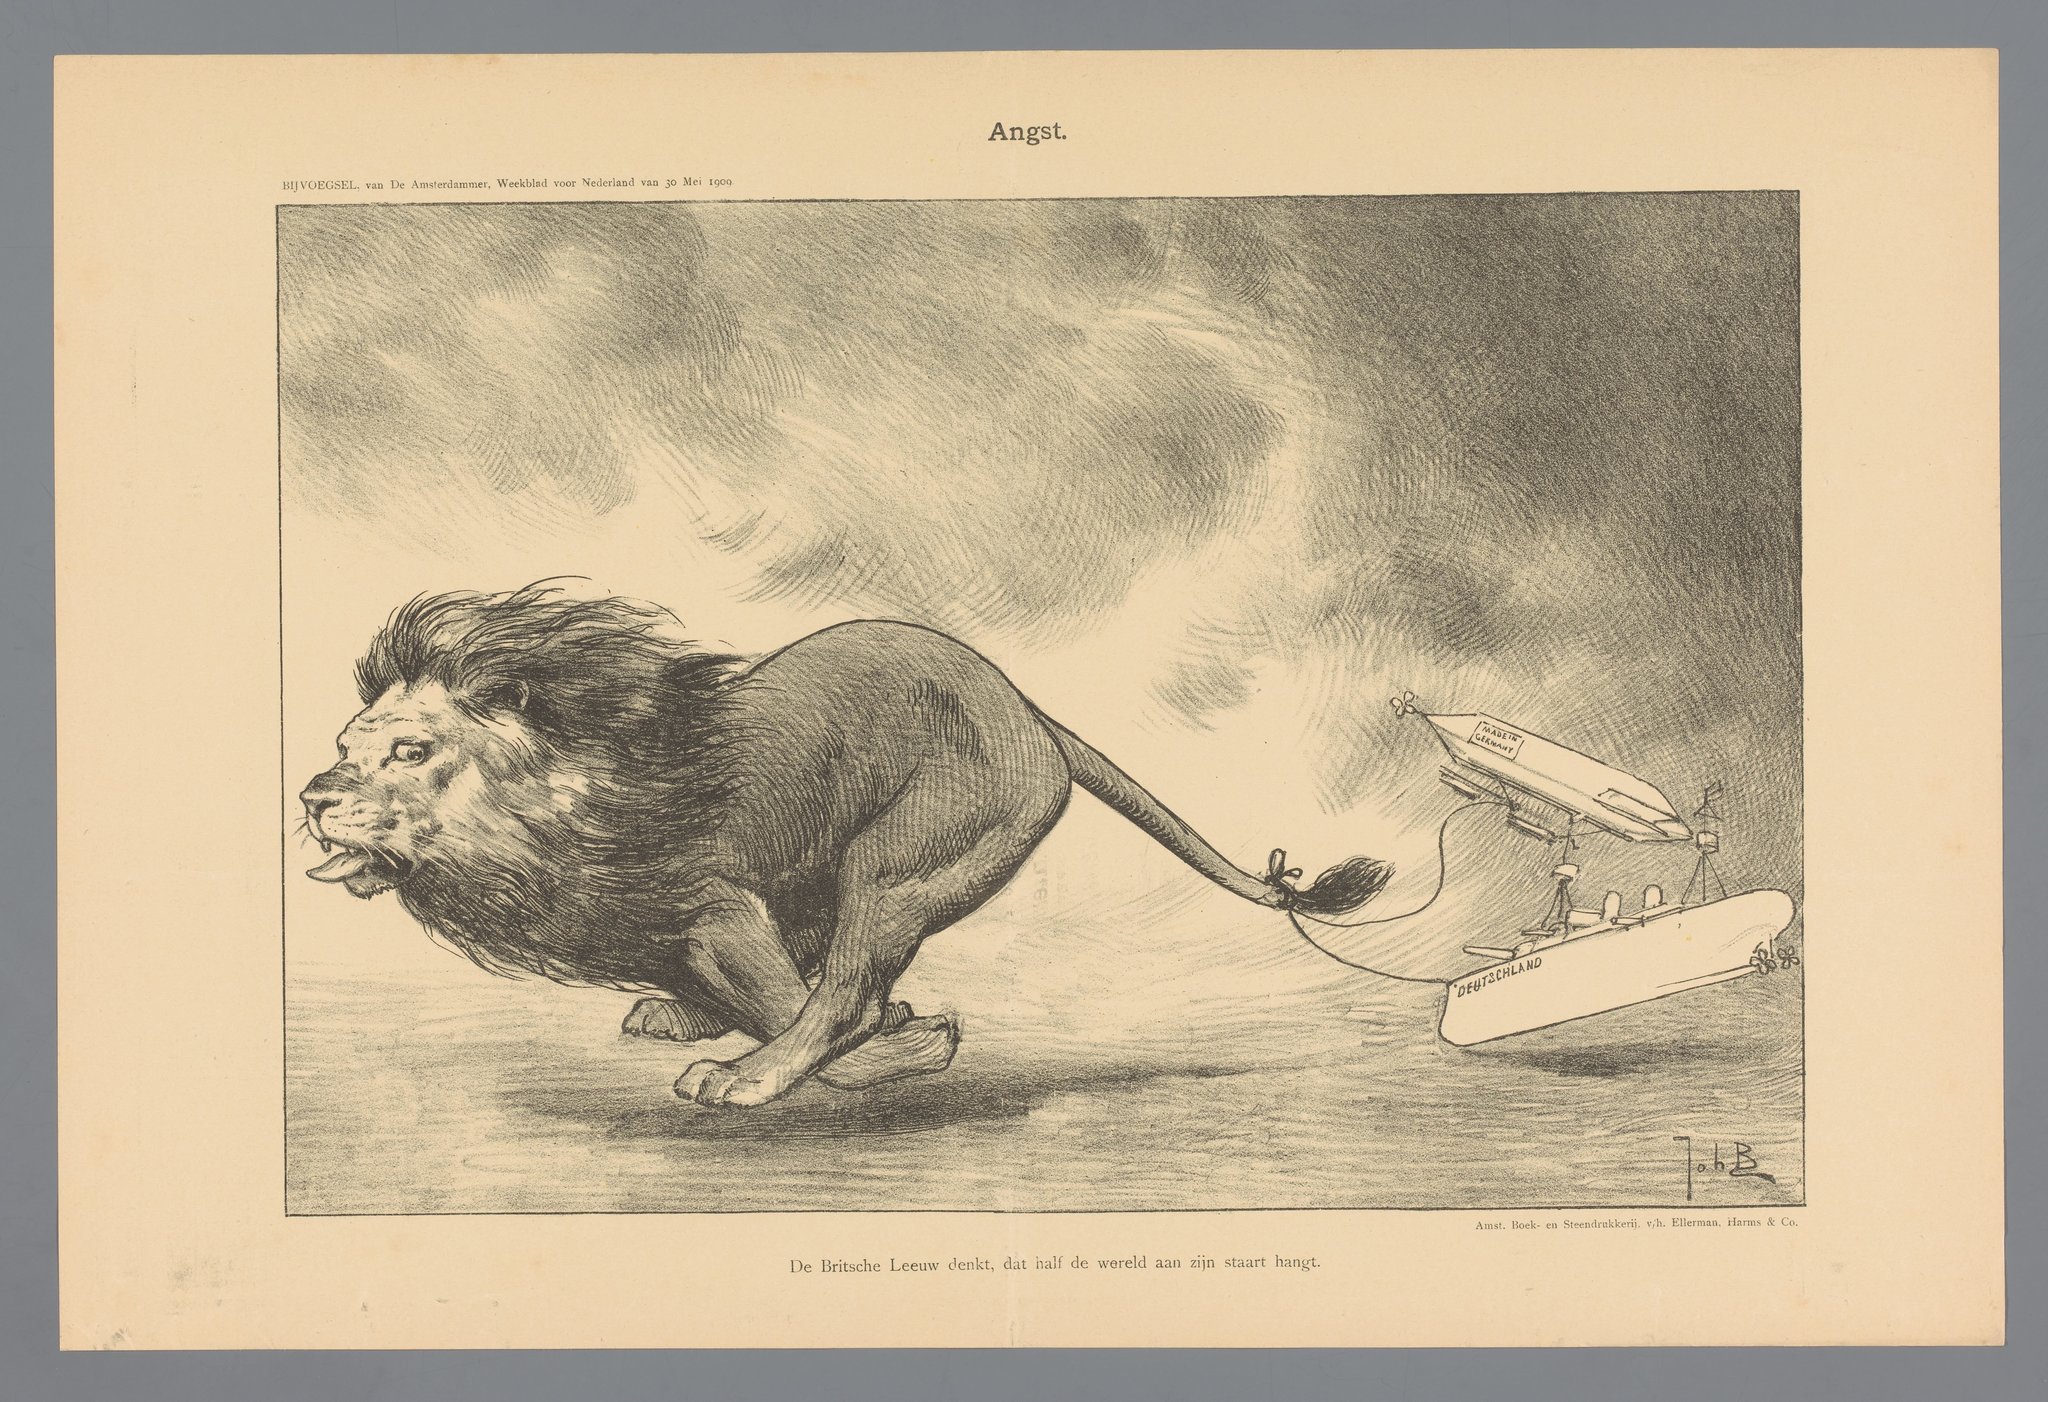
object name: cartoon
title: Angst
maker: johan braakensiek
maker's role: draughtsman, print maker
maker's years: 1858-1940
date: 1909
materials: paper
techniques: lithograph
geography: amsterdam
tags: 46c35 airship, zeppelin, beasts of prey, predatory animals: lion, political caricatures and satires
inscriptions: date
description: Prent uit het bijvoegsel van: De Amsterdammer. Weekblad voor Nederland, 30 mei 1909.